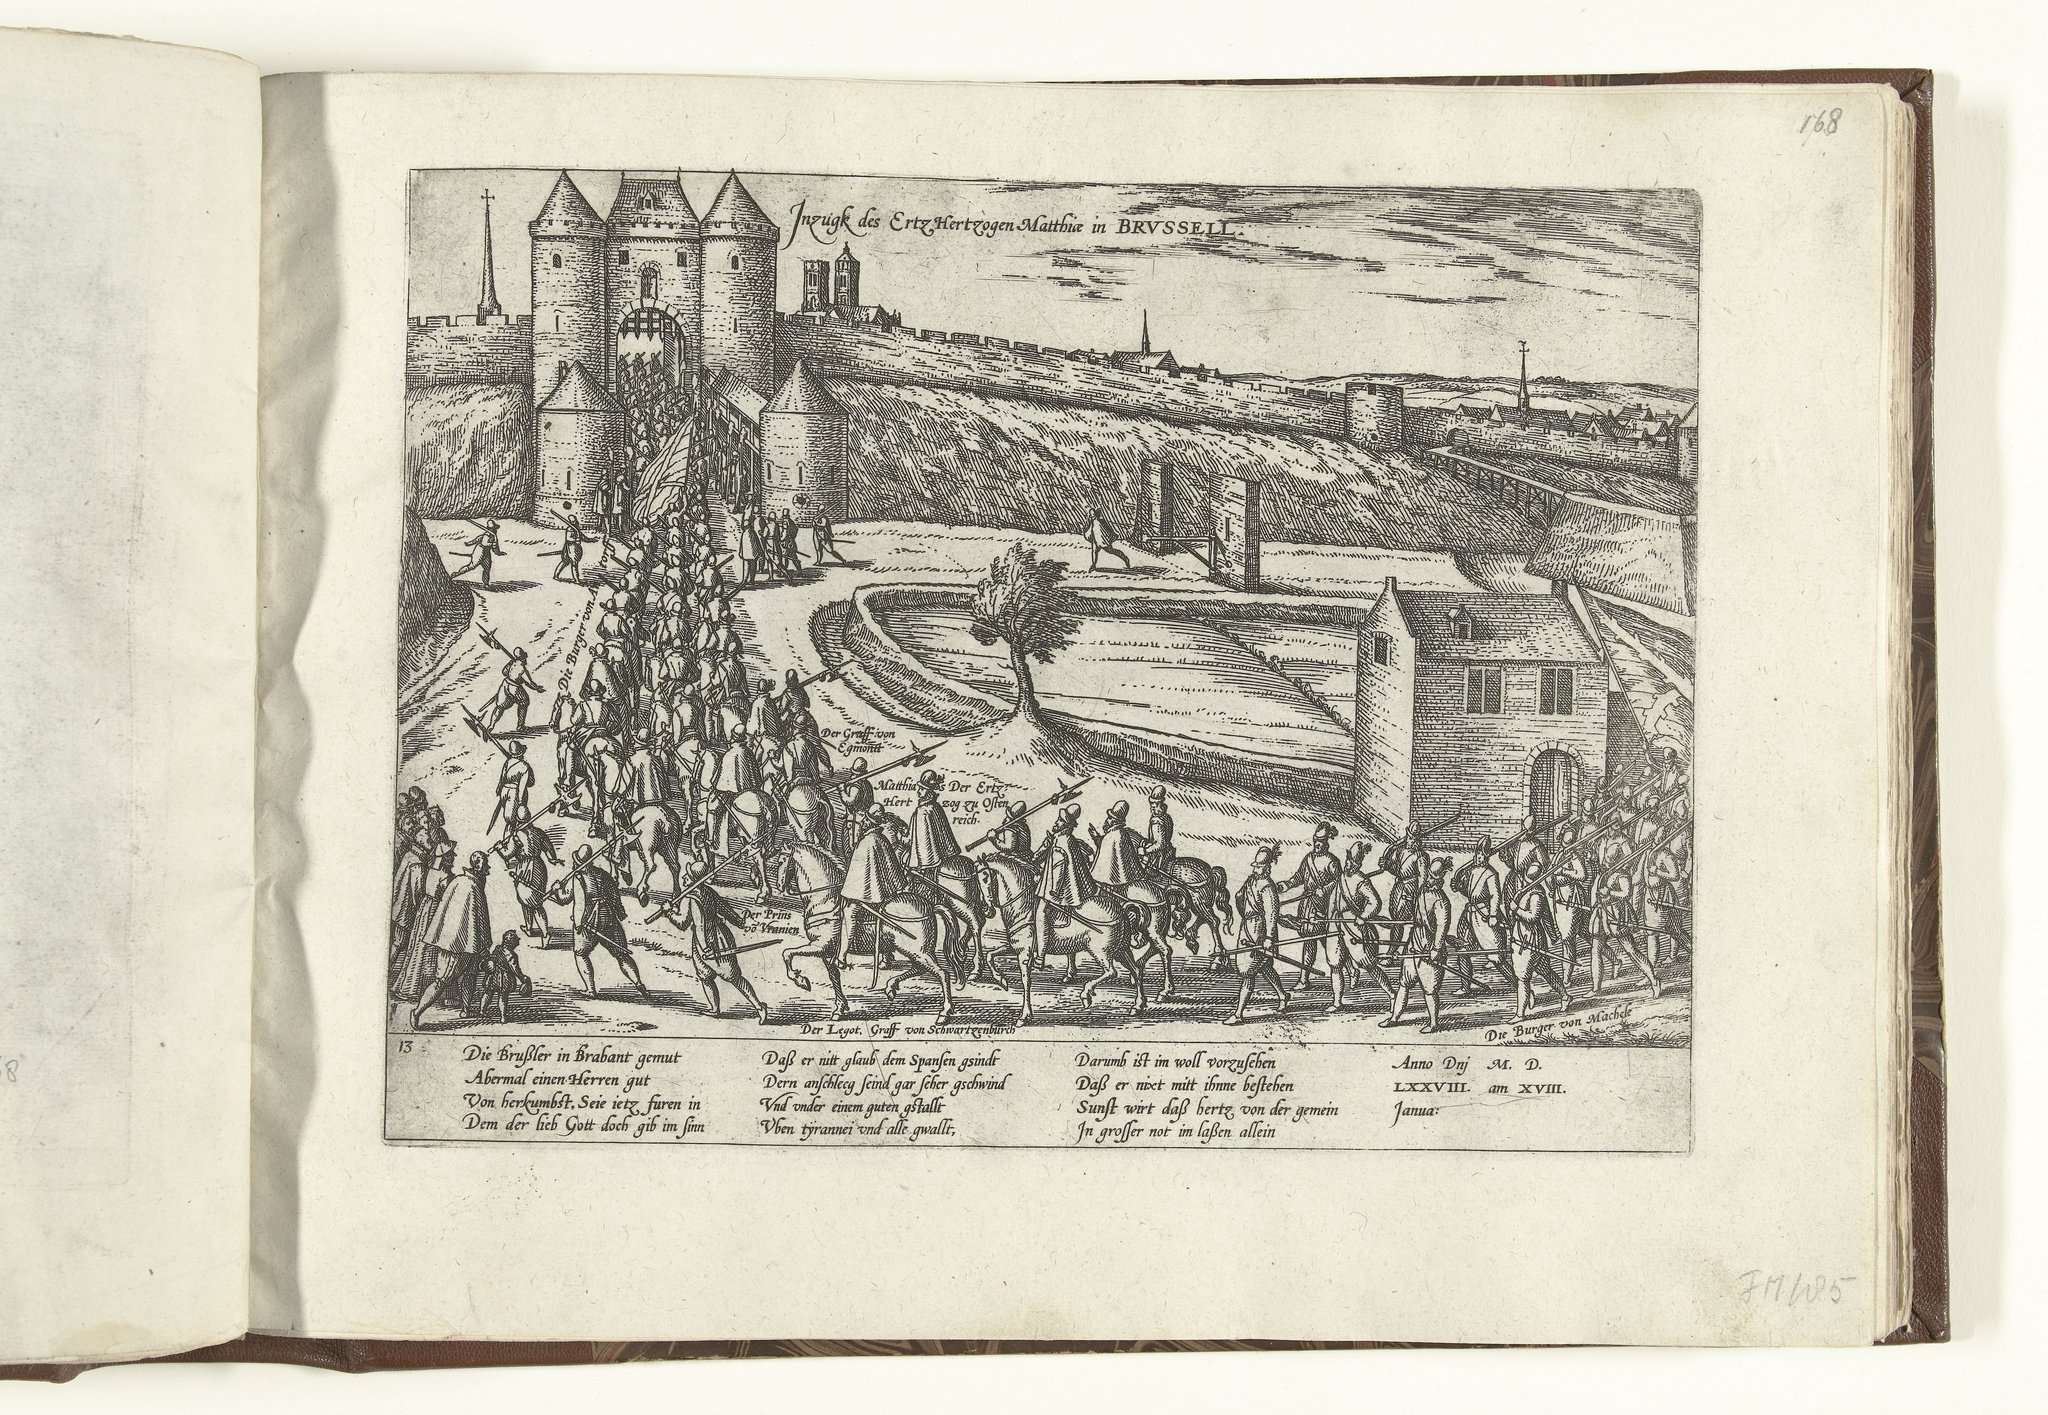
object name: print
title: Serie 8: Nederlandse Gebeurtenissen, 1577-1583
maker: frans hogenberg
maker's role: print maker, publisher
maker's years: 1538-1590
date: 1578-1580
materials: paper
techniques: etching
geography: cologne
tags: vienna, matthias van oostenrijk (rooms-duits keizer), delft, william i (prince of orange), triumphal entry and public reception, pageant, 'entrée solennelle', 'joyeuse entrée', brussels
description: Intocht van aartshertog Matthias van Oostenrijk te Brussel, 18 januari 1578. Matthias te paard in stoet begeleid door prins van Oranje, de graaf van Schwarzburg, graaf van Egmond en burgers van Antwerpen en Mechelen trekt in de richting van de stadspoort. Met onderschrift van 12 regels in het Duits. Genummerd: 13.